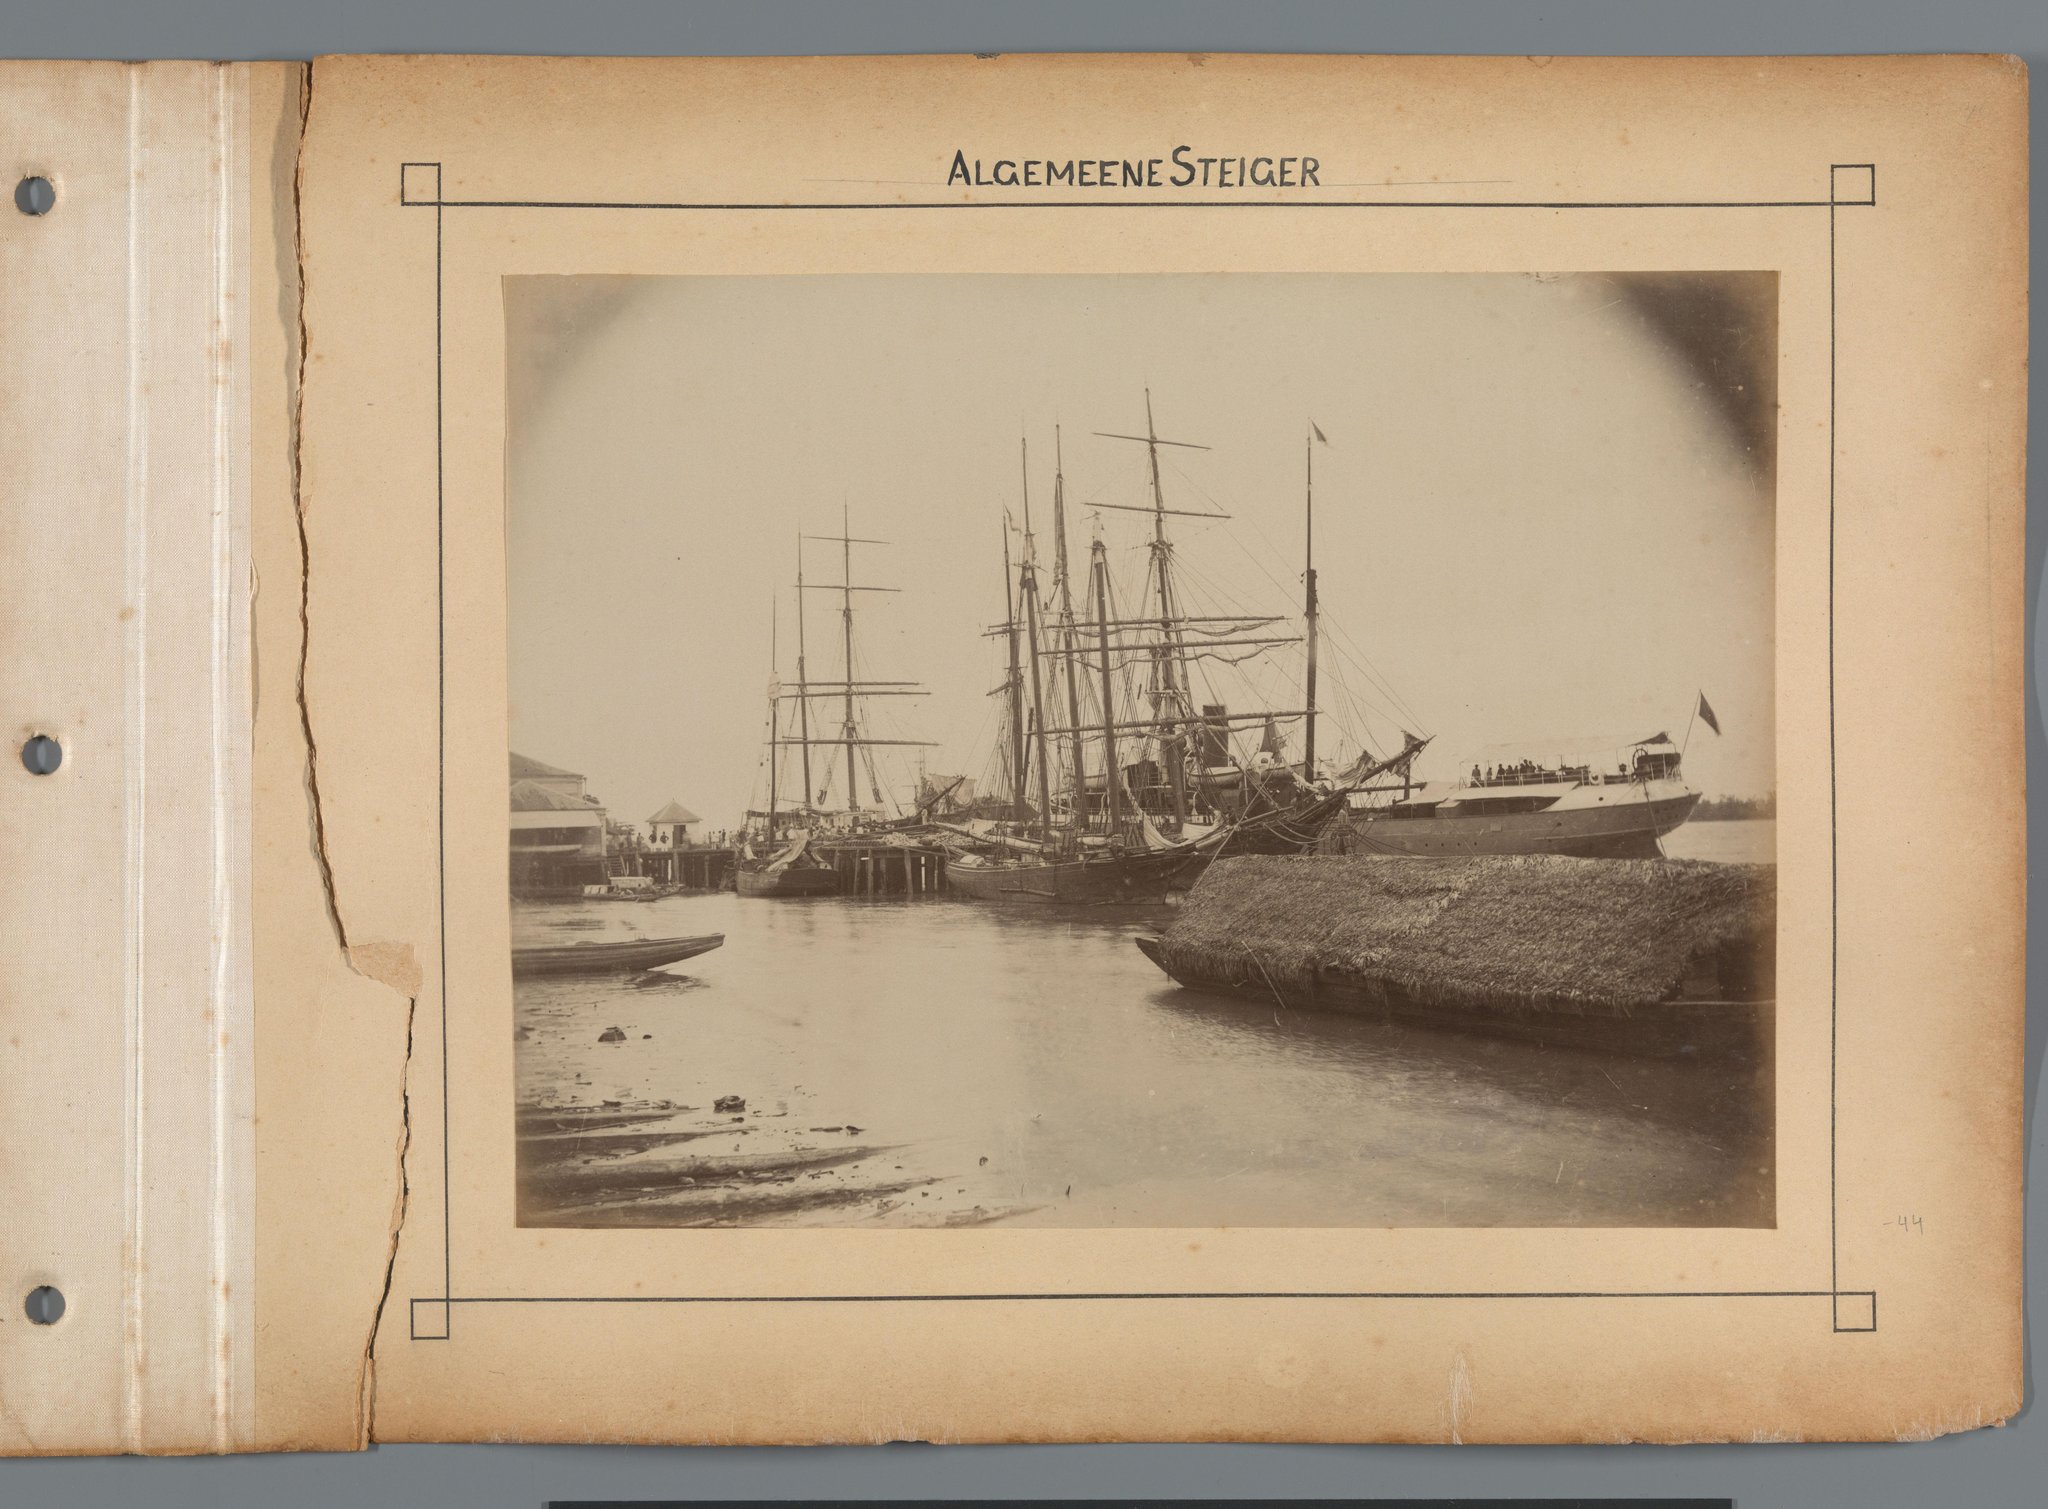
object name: photograph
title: Algemeene Steiger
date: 1898-1902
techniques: albumen print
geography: suriname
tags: pier, quay, wharf, suriname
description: Schepen aan de Algemene steiger aan de Waterkant, Paramaribo.